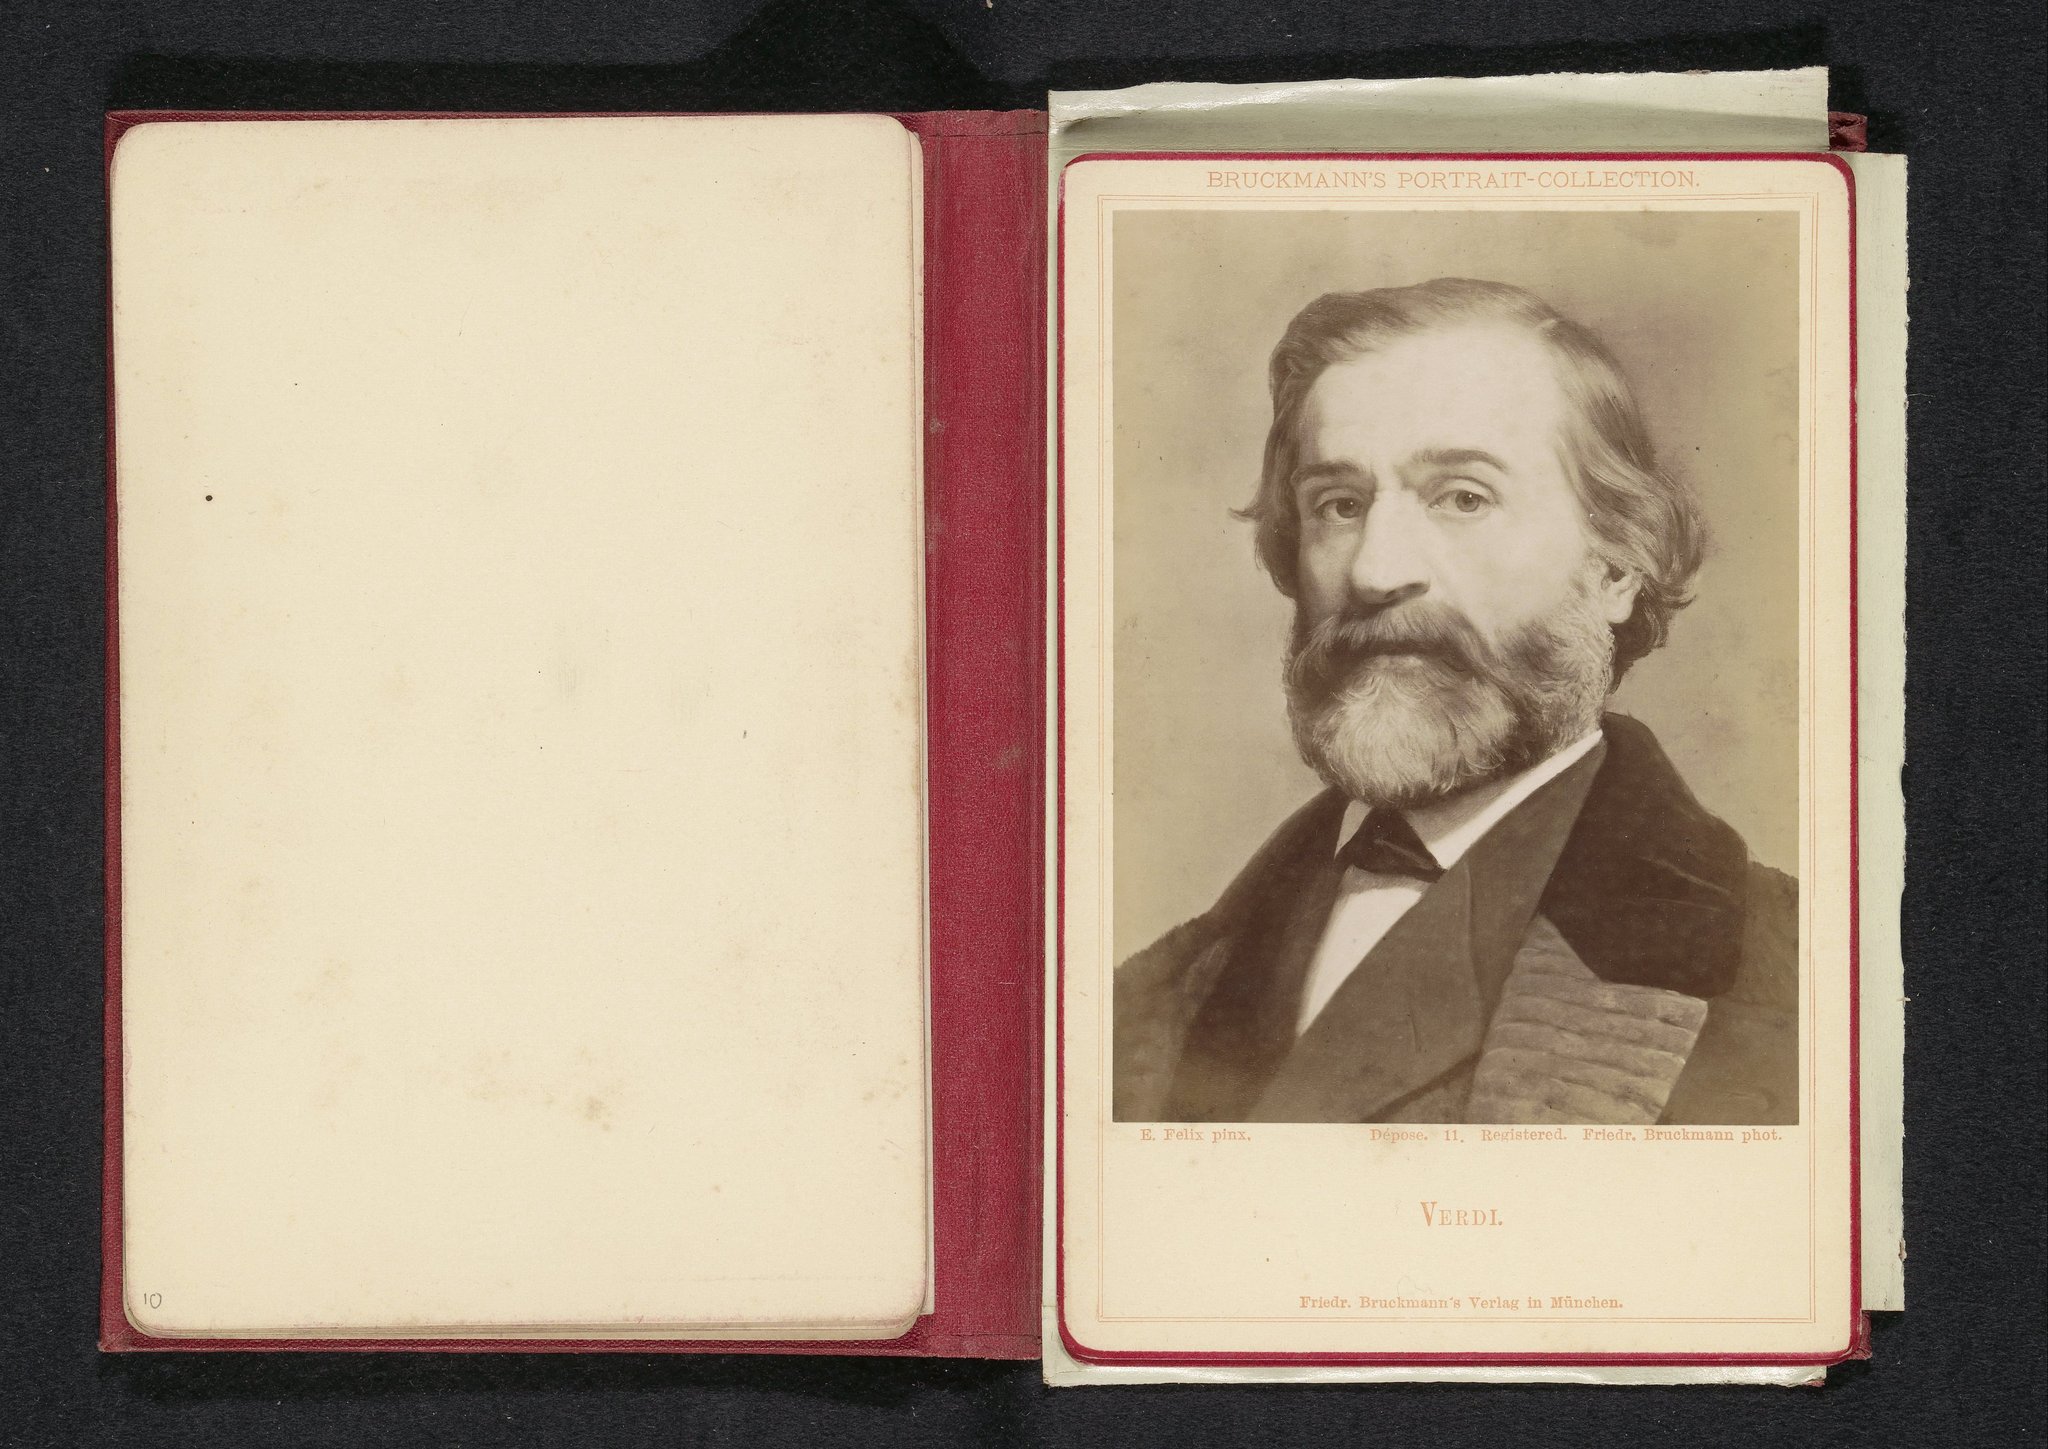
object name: page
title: Bruckmann's Portrait-Collection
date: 1868-1878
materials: photographic support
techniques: albumen print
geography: munich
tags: portrait of composer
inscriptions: number: ‘11.’